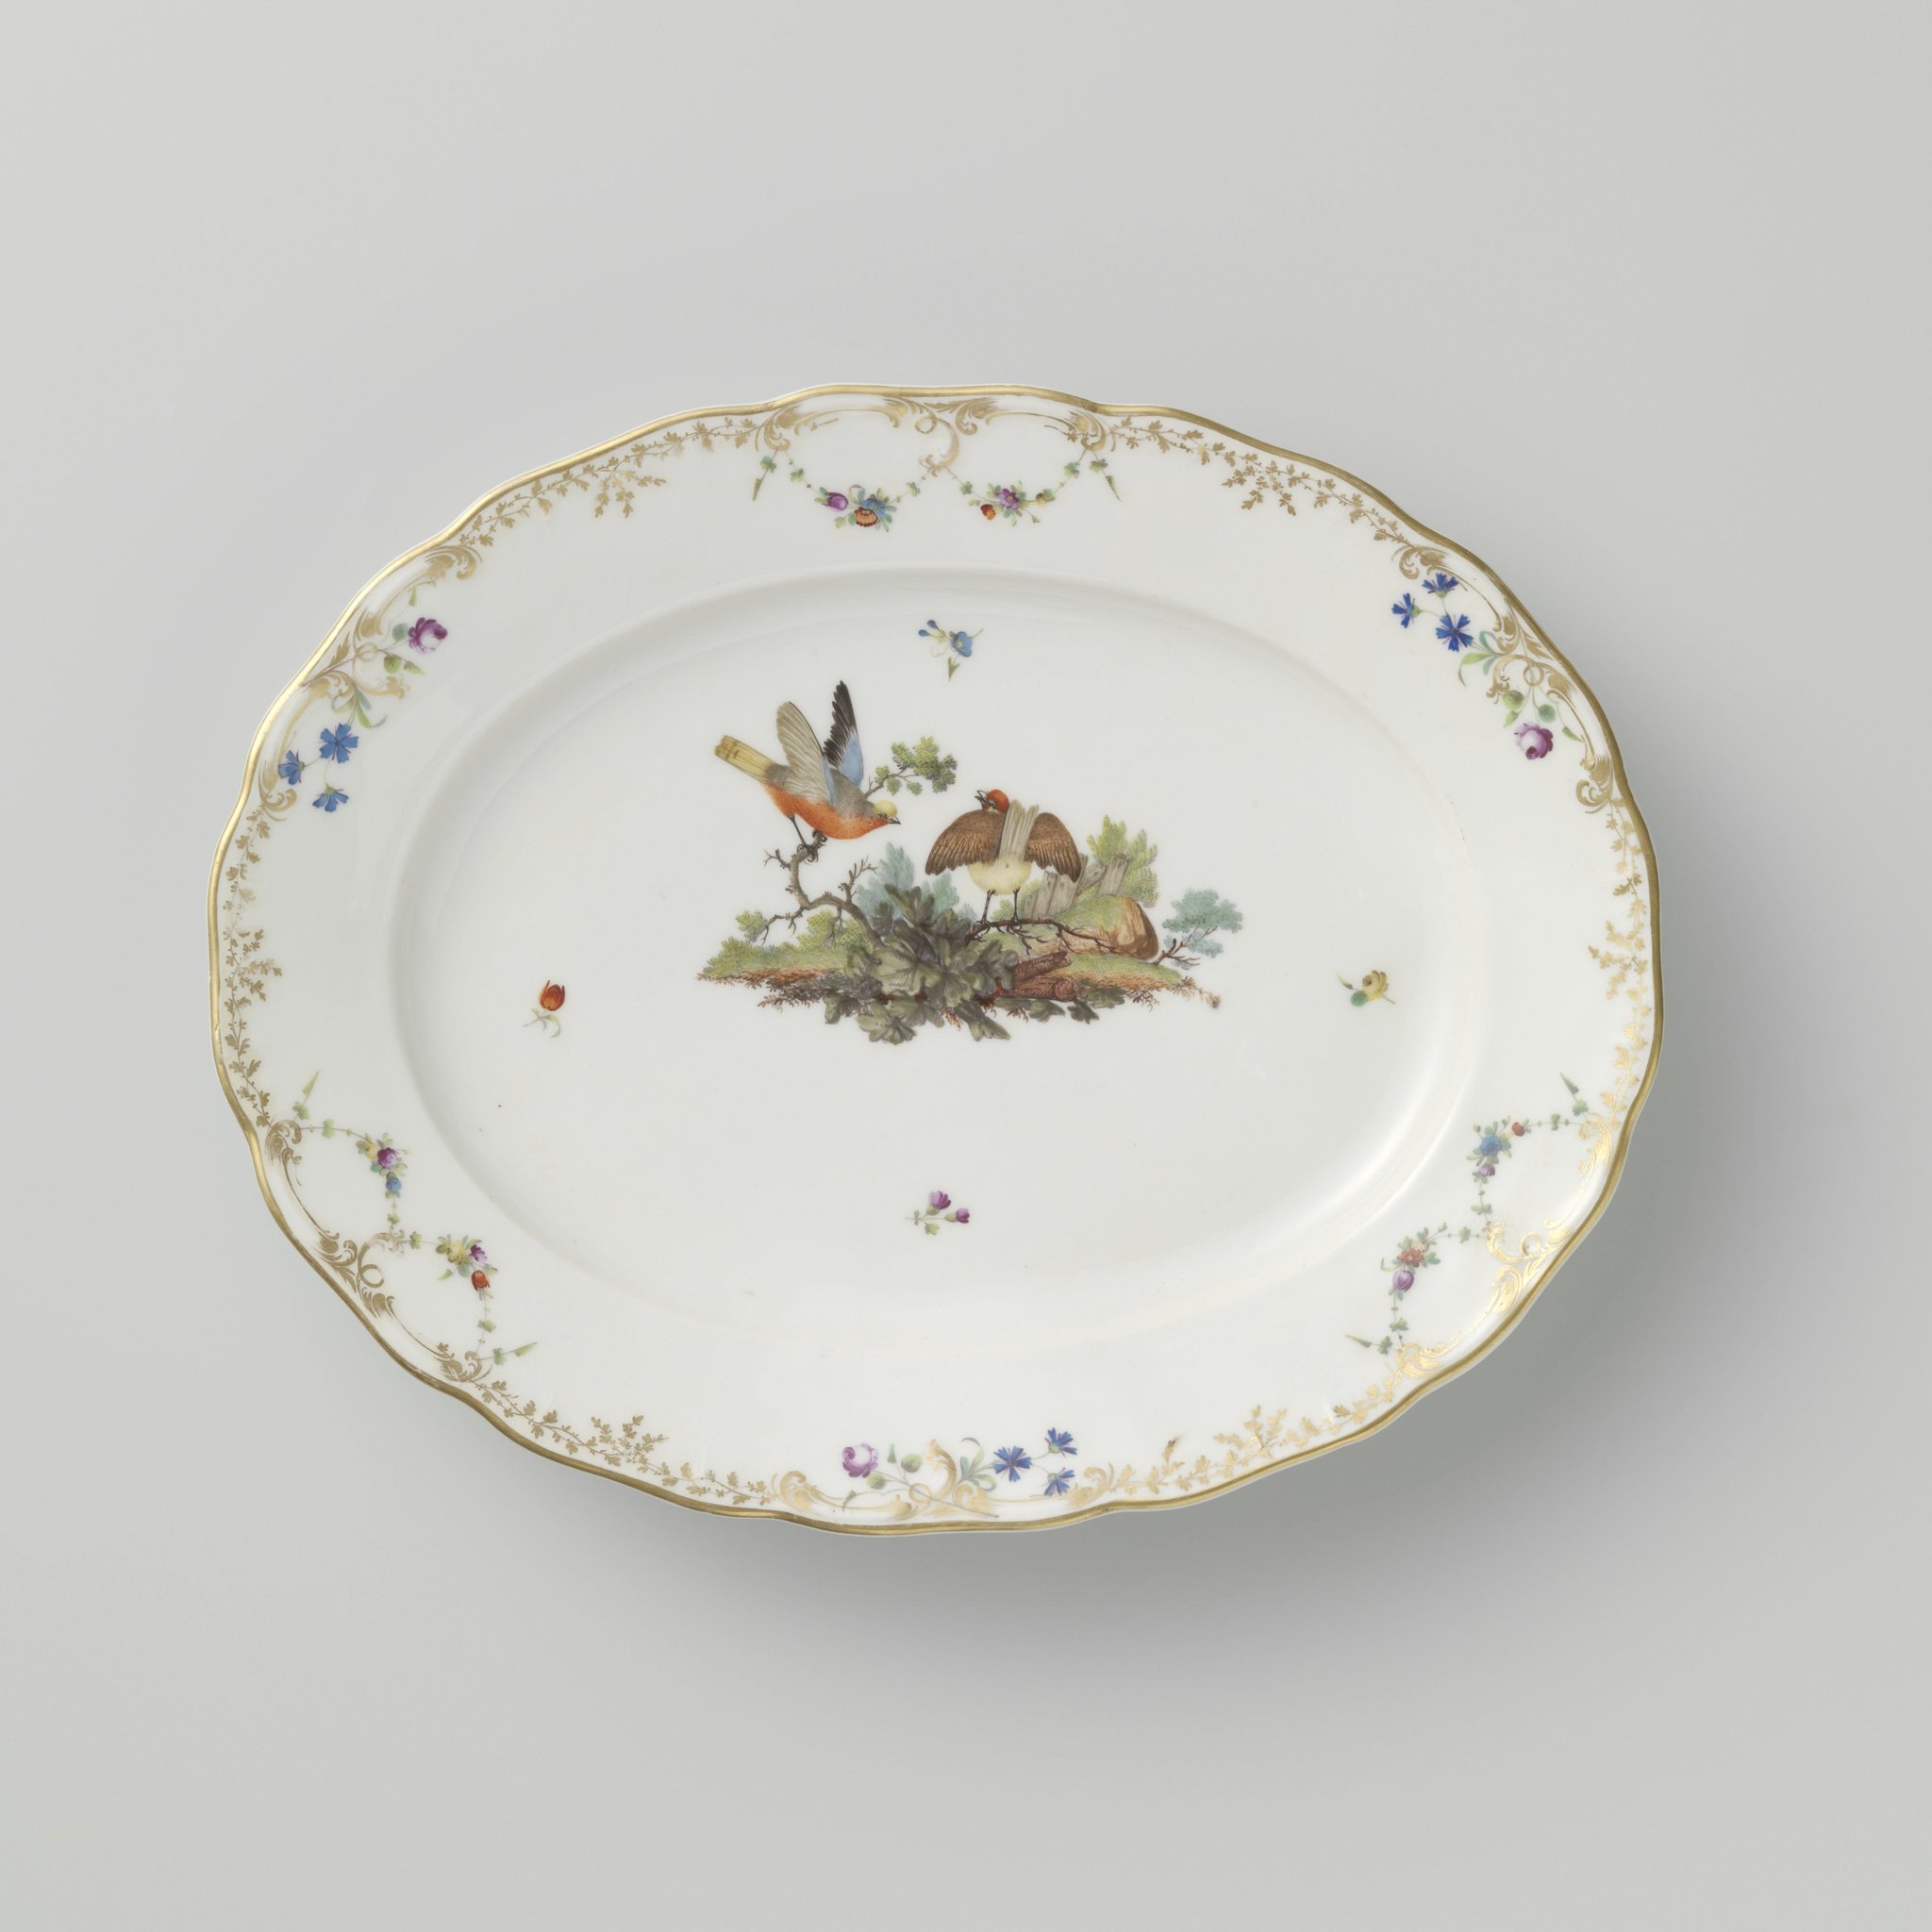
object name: platter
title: Vruchtenschaal, beschilderd met bladranken en bloemguirlandes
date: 1784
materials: porcelain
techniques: painted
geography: loosdrecht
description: Vruchtenschaal op onderschotel langs de randen veelkleurig versierd met bladranken en bloemguirlandes. De bodem en de voet van de schaal is opengewerkt met boven en onder een vogel op een grondje. Gemerkt: mand M.O.L.* en de schaal Amstel.